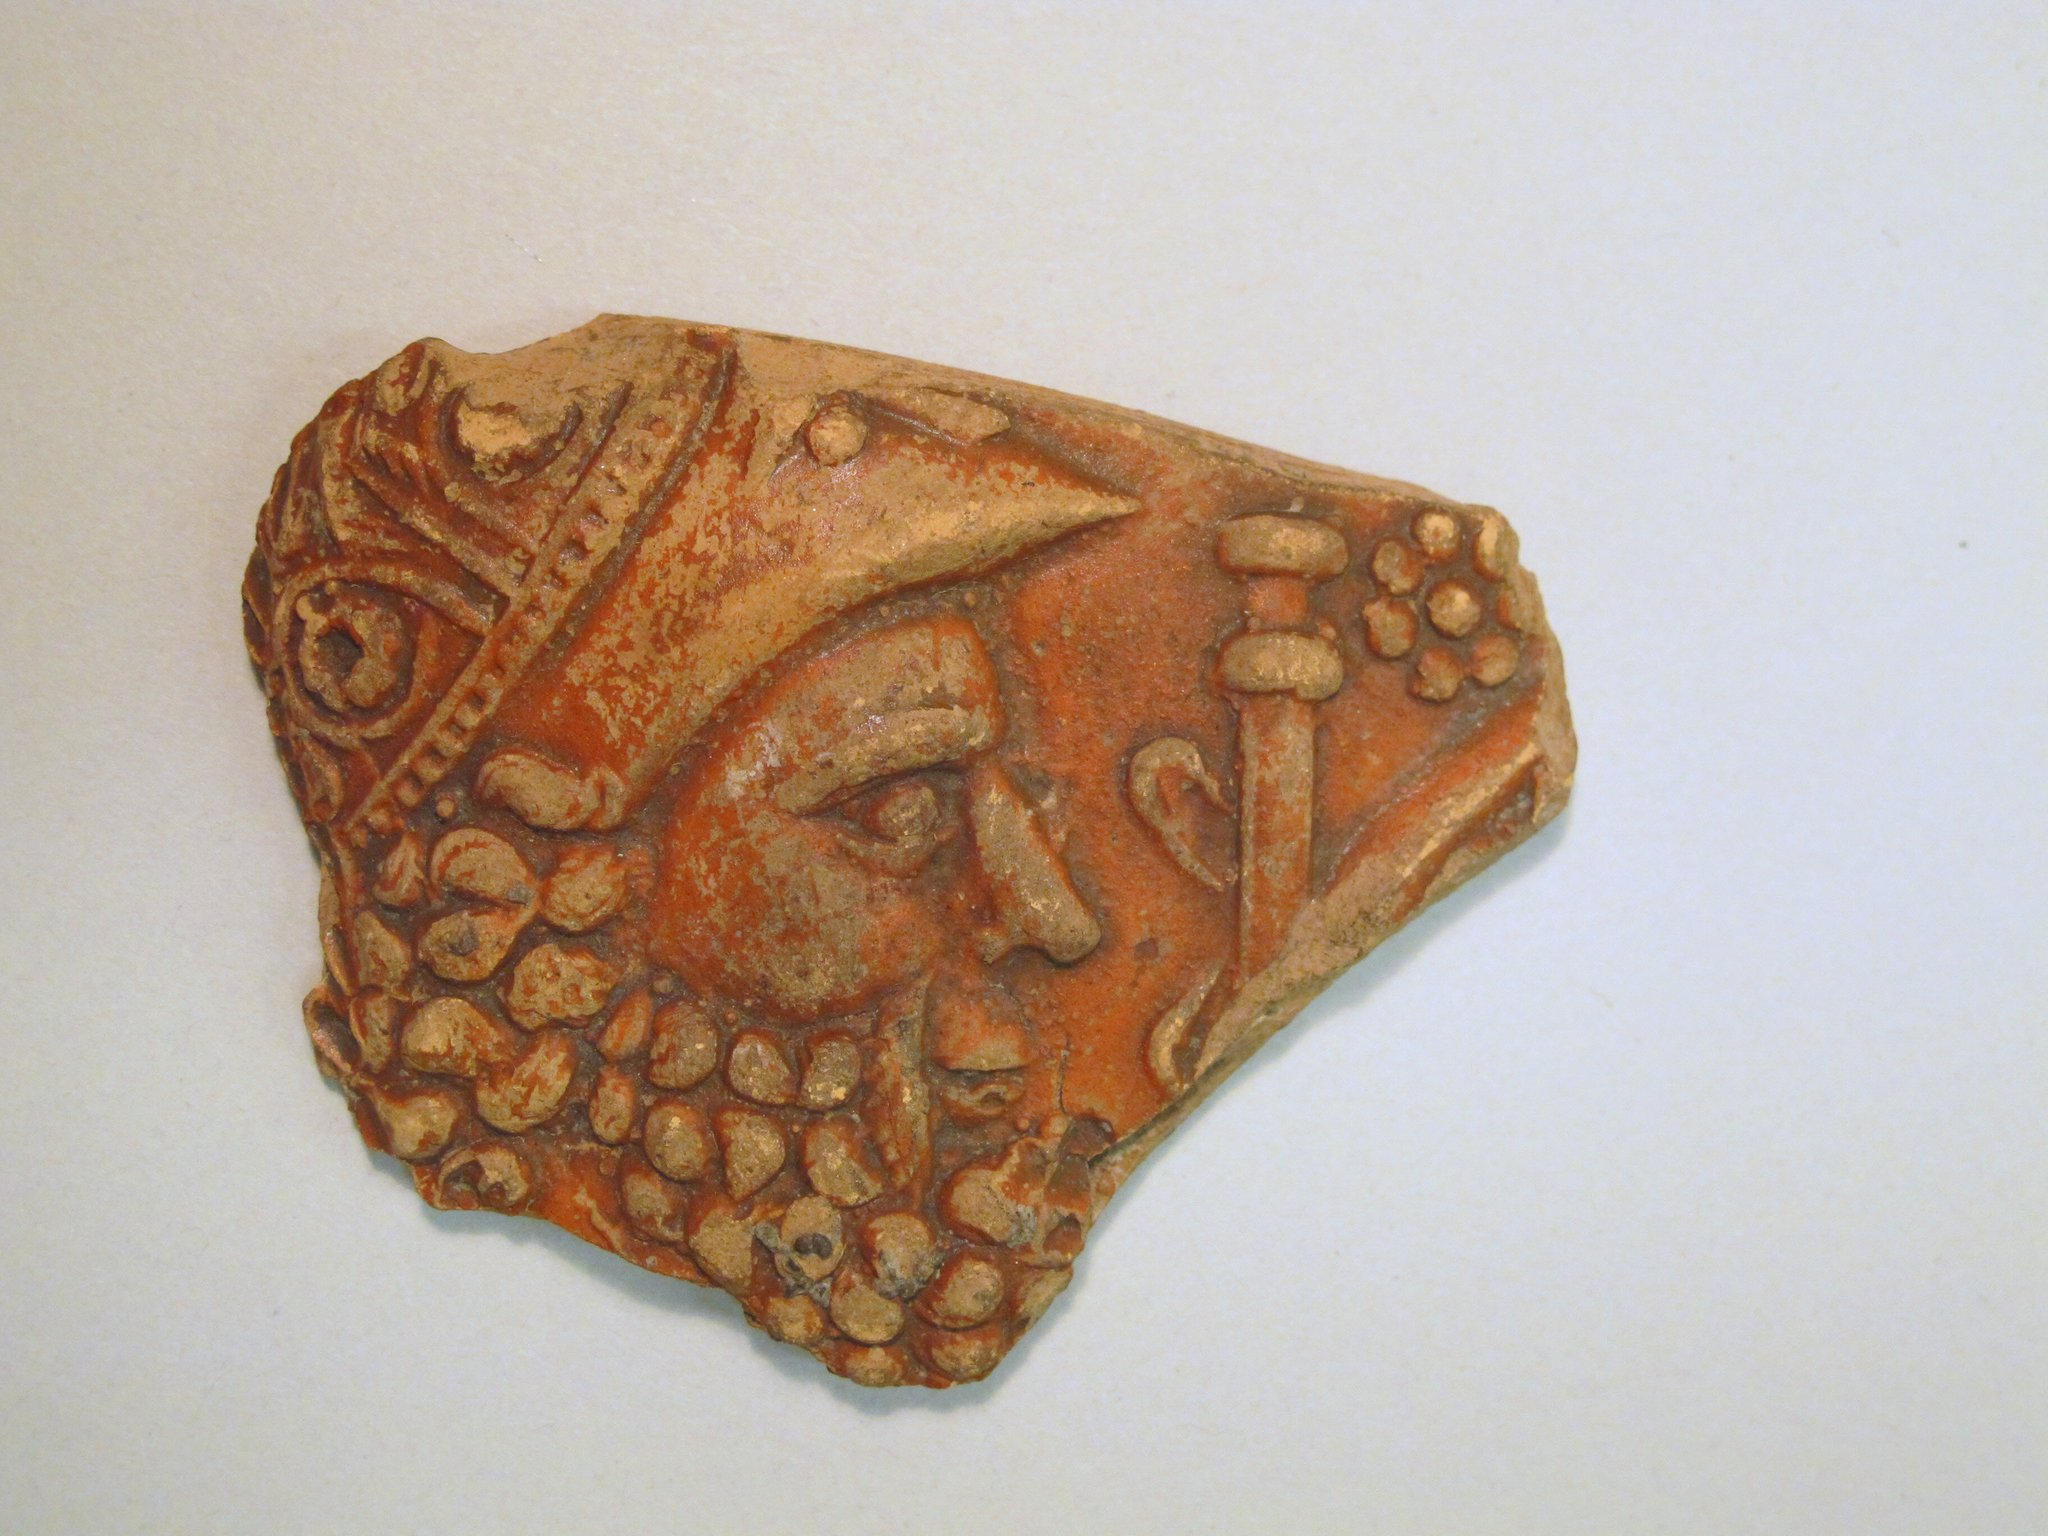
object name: vase fragment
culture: roman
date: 670 BCE-330 CE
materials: terracotta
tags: helmets,heads